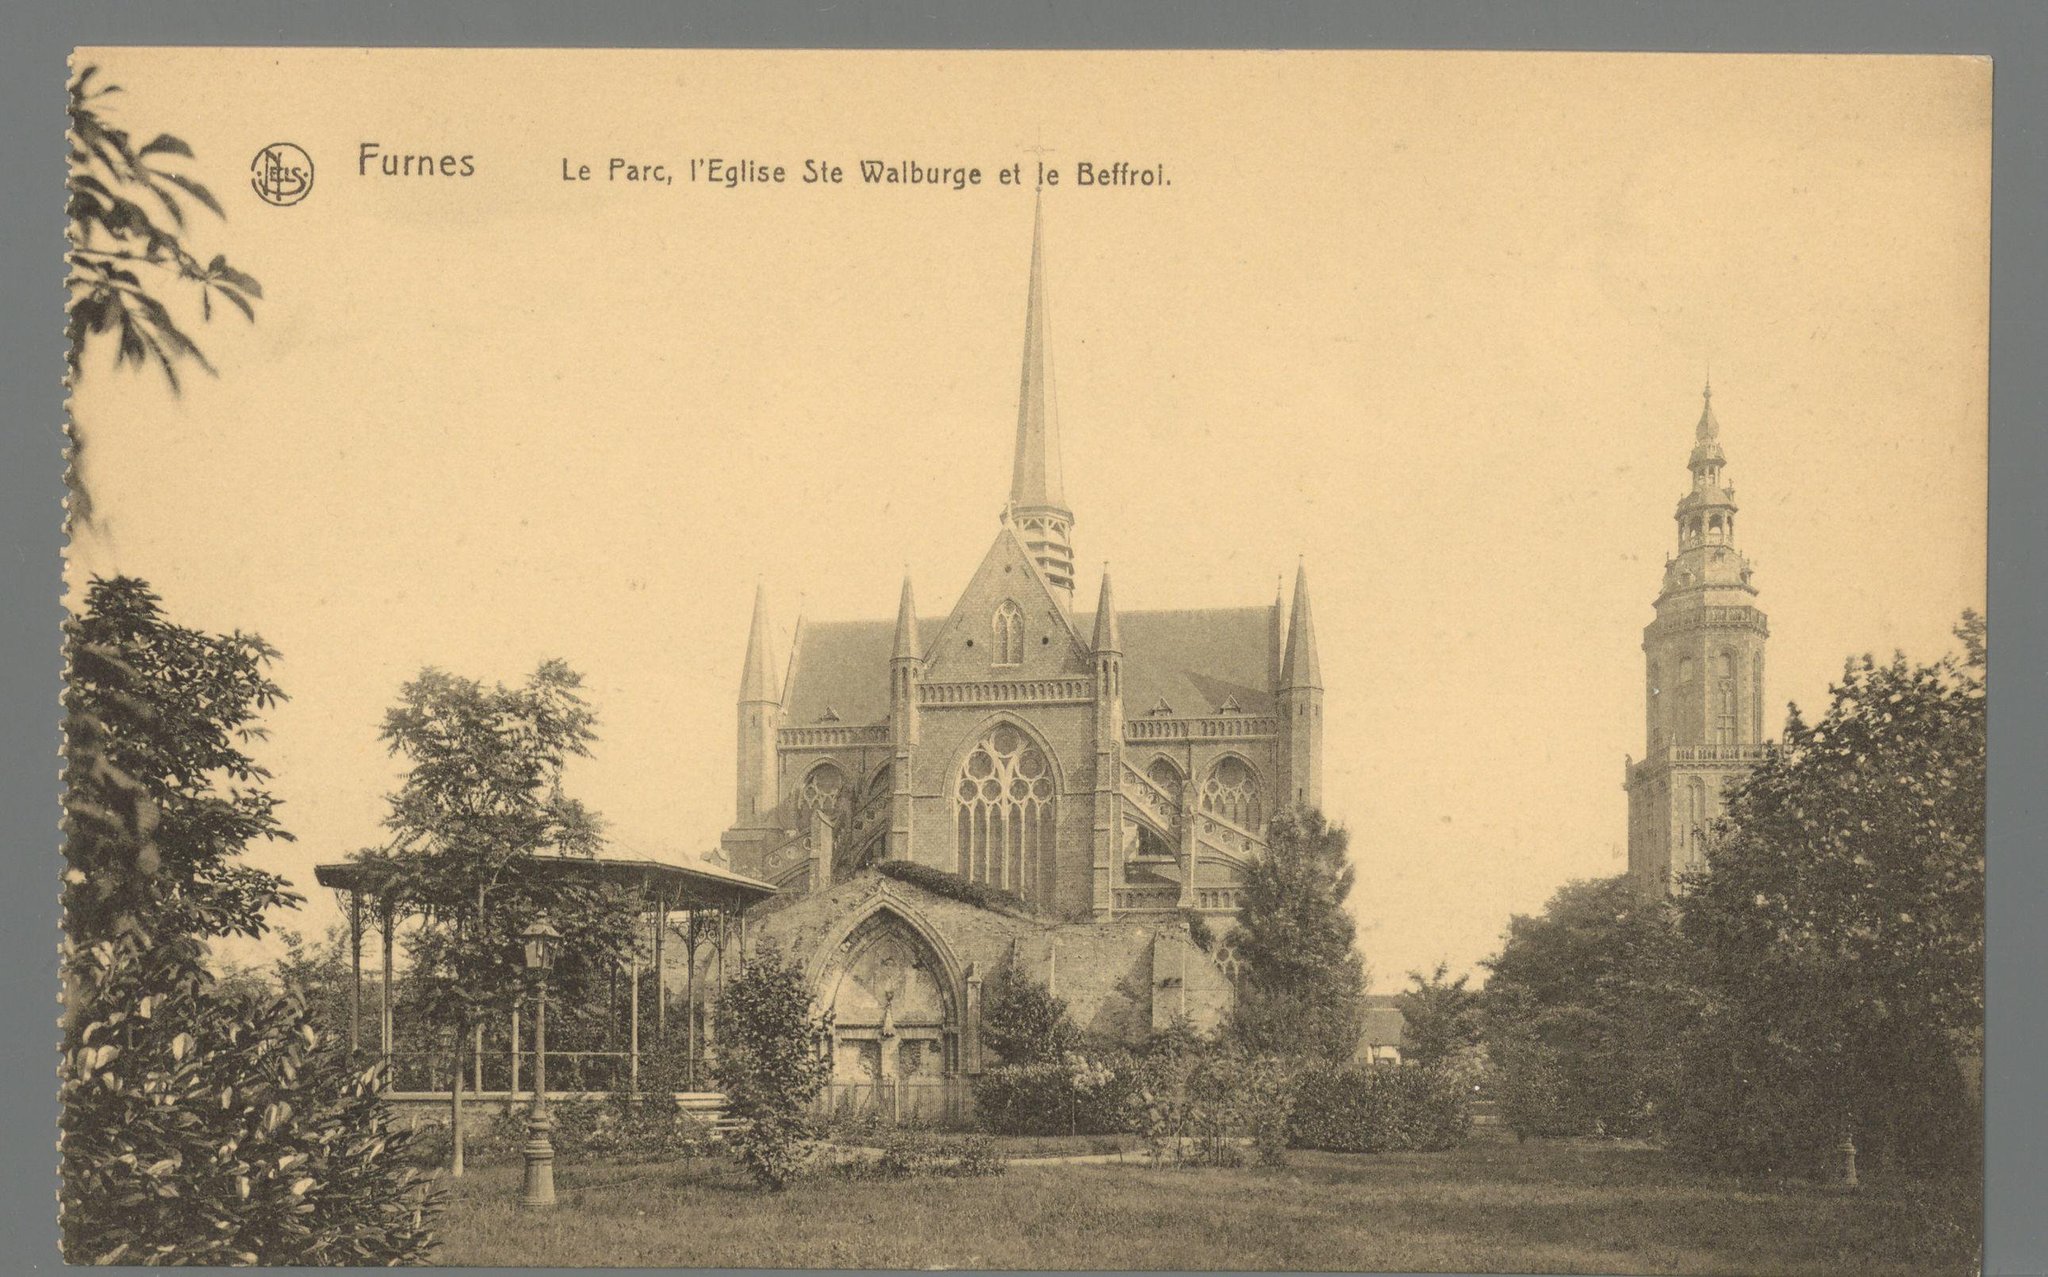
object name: ansichtkaart, prentbriefkaart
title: Furnes. Le parc, l'eglise Ste Walburge et le beffroi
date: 1913-1918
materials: cardboard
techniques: photograph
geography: brussels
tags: roman catholic church, public gardens, park